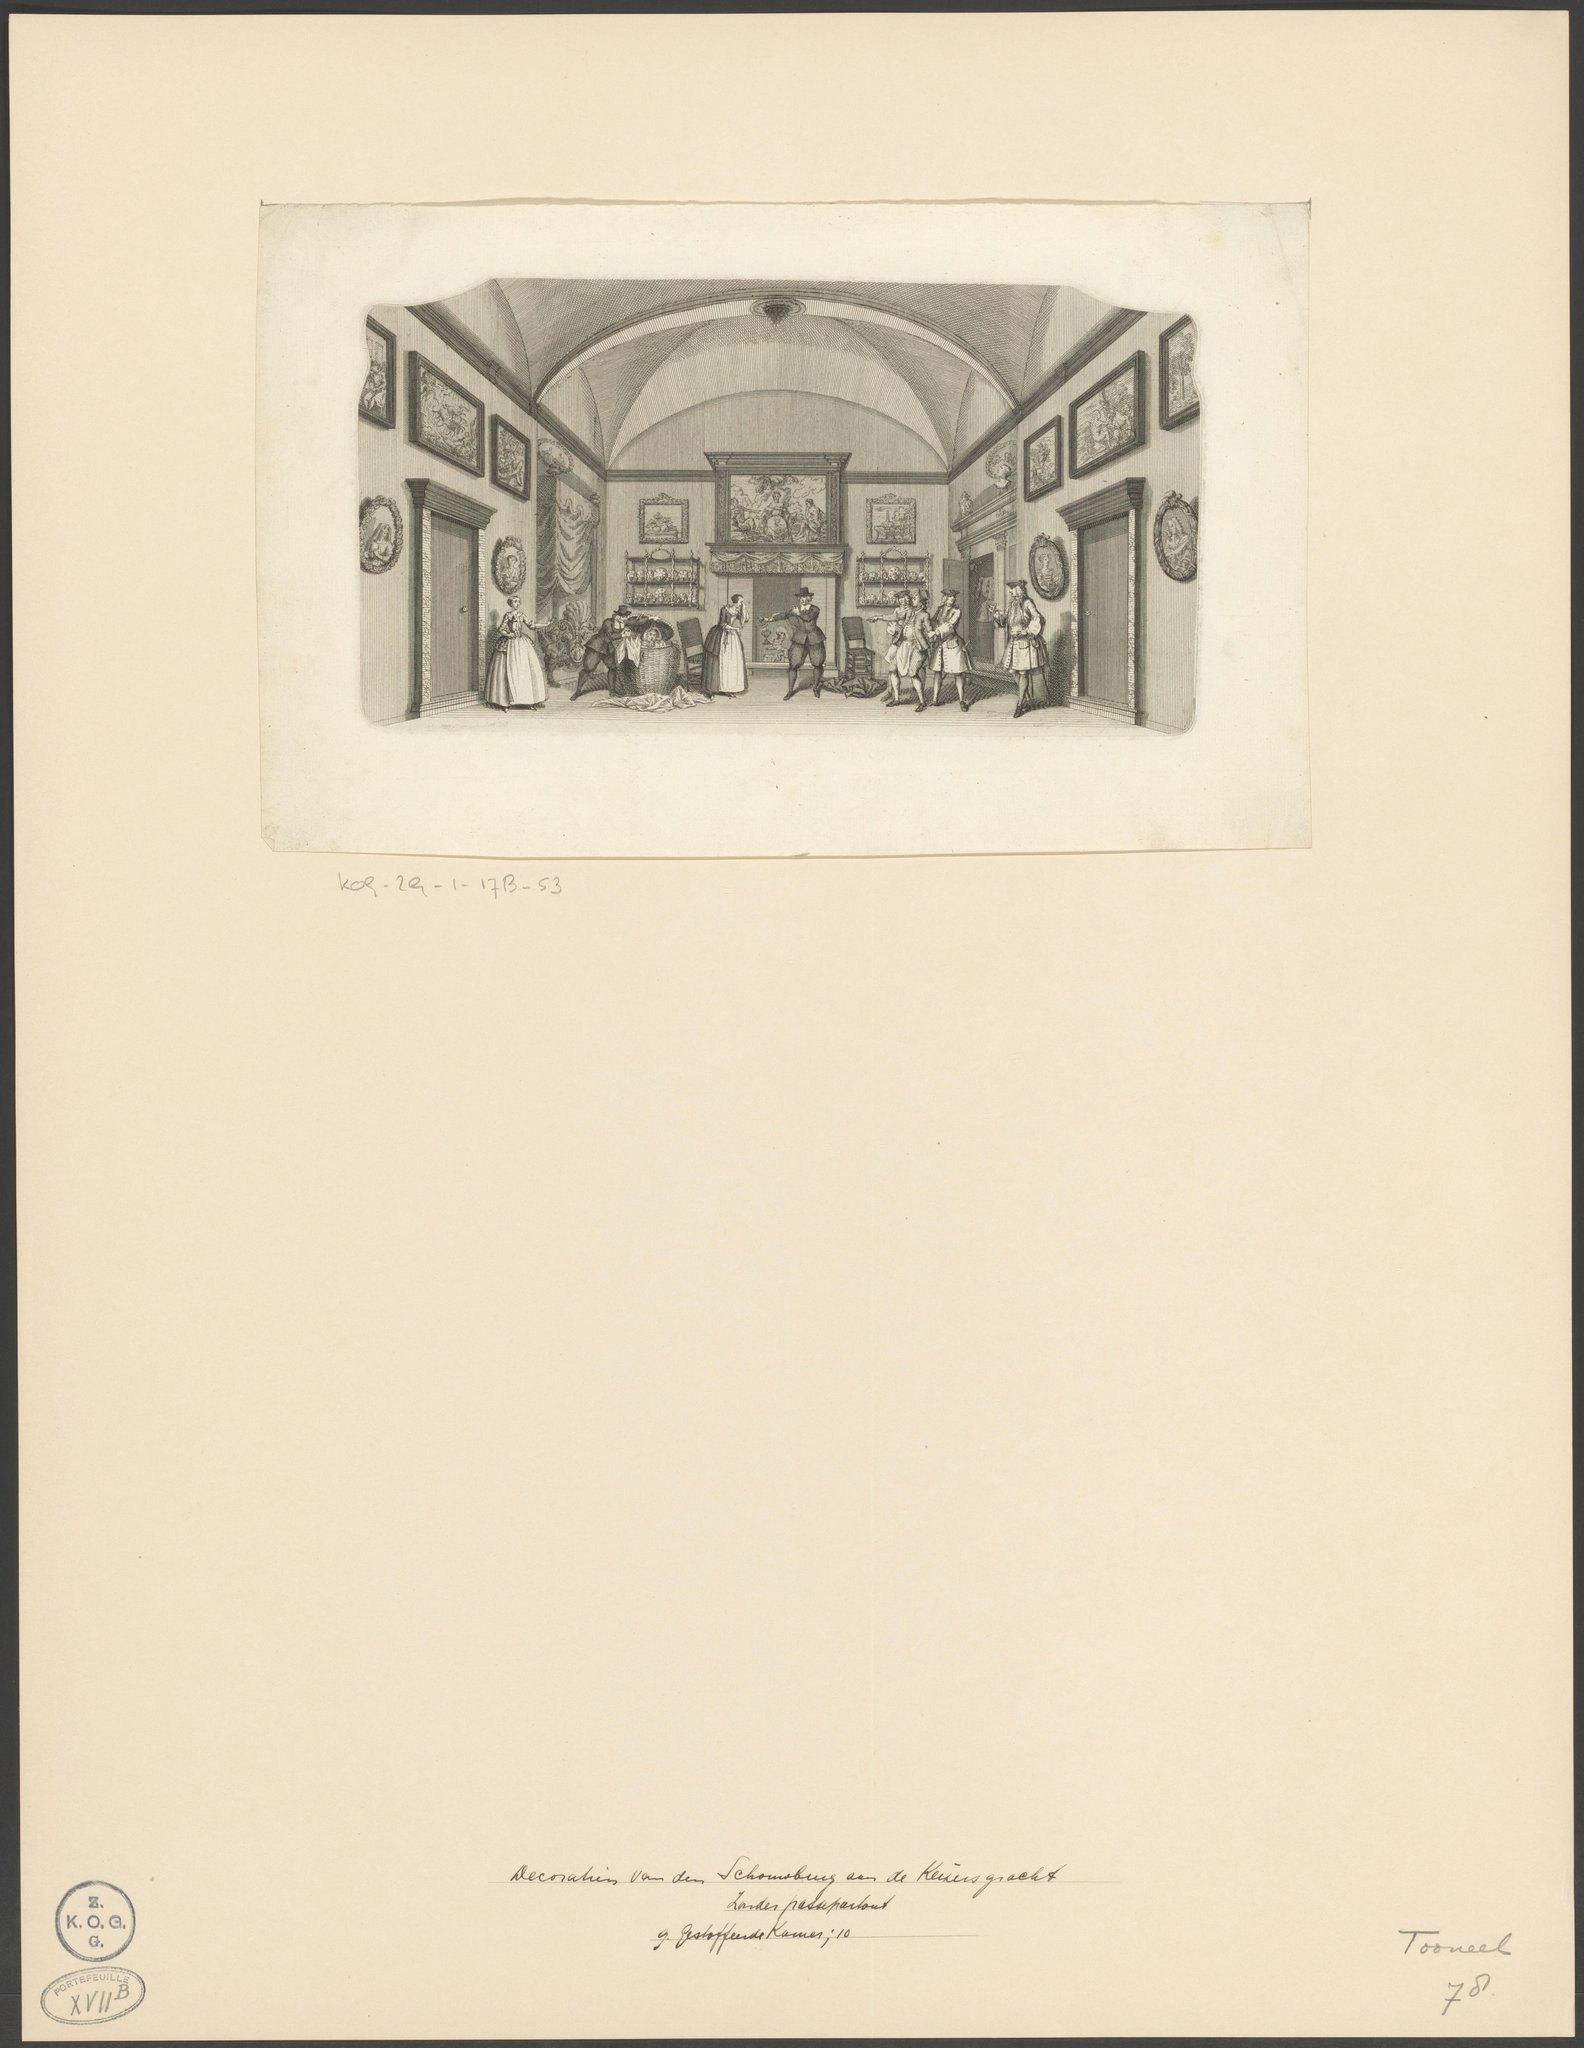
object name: print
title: Toneeldecors van de Amsterdamse Schouwburg, ca. 1760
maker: adolf van der laan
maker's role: draughtsman, print maker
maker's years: 1689-1742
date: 1736-1738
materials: paper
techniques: engraving, etching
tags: theatre, theatrical performance, stage design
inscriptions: collector's mark: Lugt 1641, stamp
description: Het coulissendecor De Gestoffeerde Kamer met scène uit: De ontdekte schyndeugd. Alleen het decor gedrukt van een aparte plaat, dus zonder het passe-partout. Onderdeel van een serie van twaalf toneeldecors van de Amsterdamse Schouwburg op de Keizersgracht. Onderwerpsrubrieken binnen de Atlas Zeden en Gewoonten: Schoone kunsten, Tooneel, Schouwburg op de Keizersgracht (1637 – 1772).